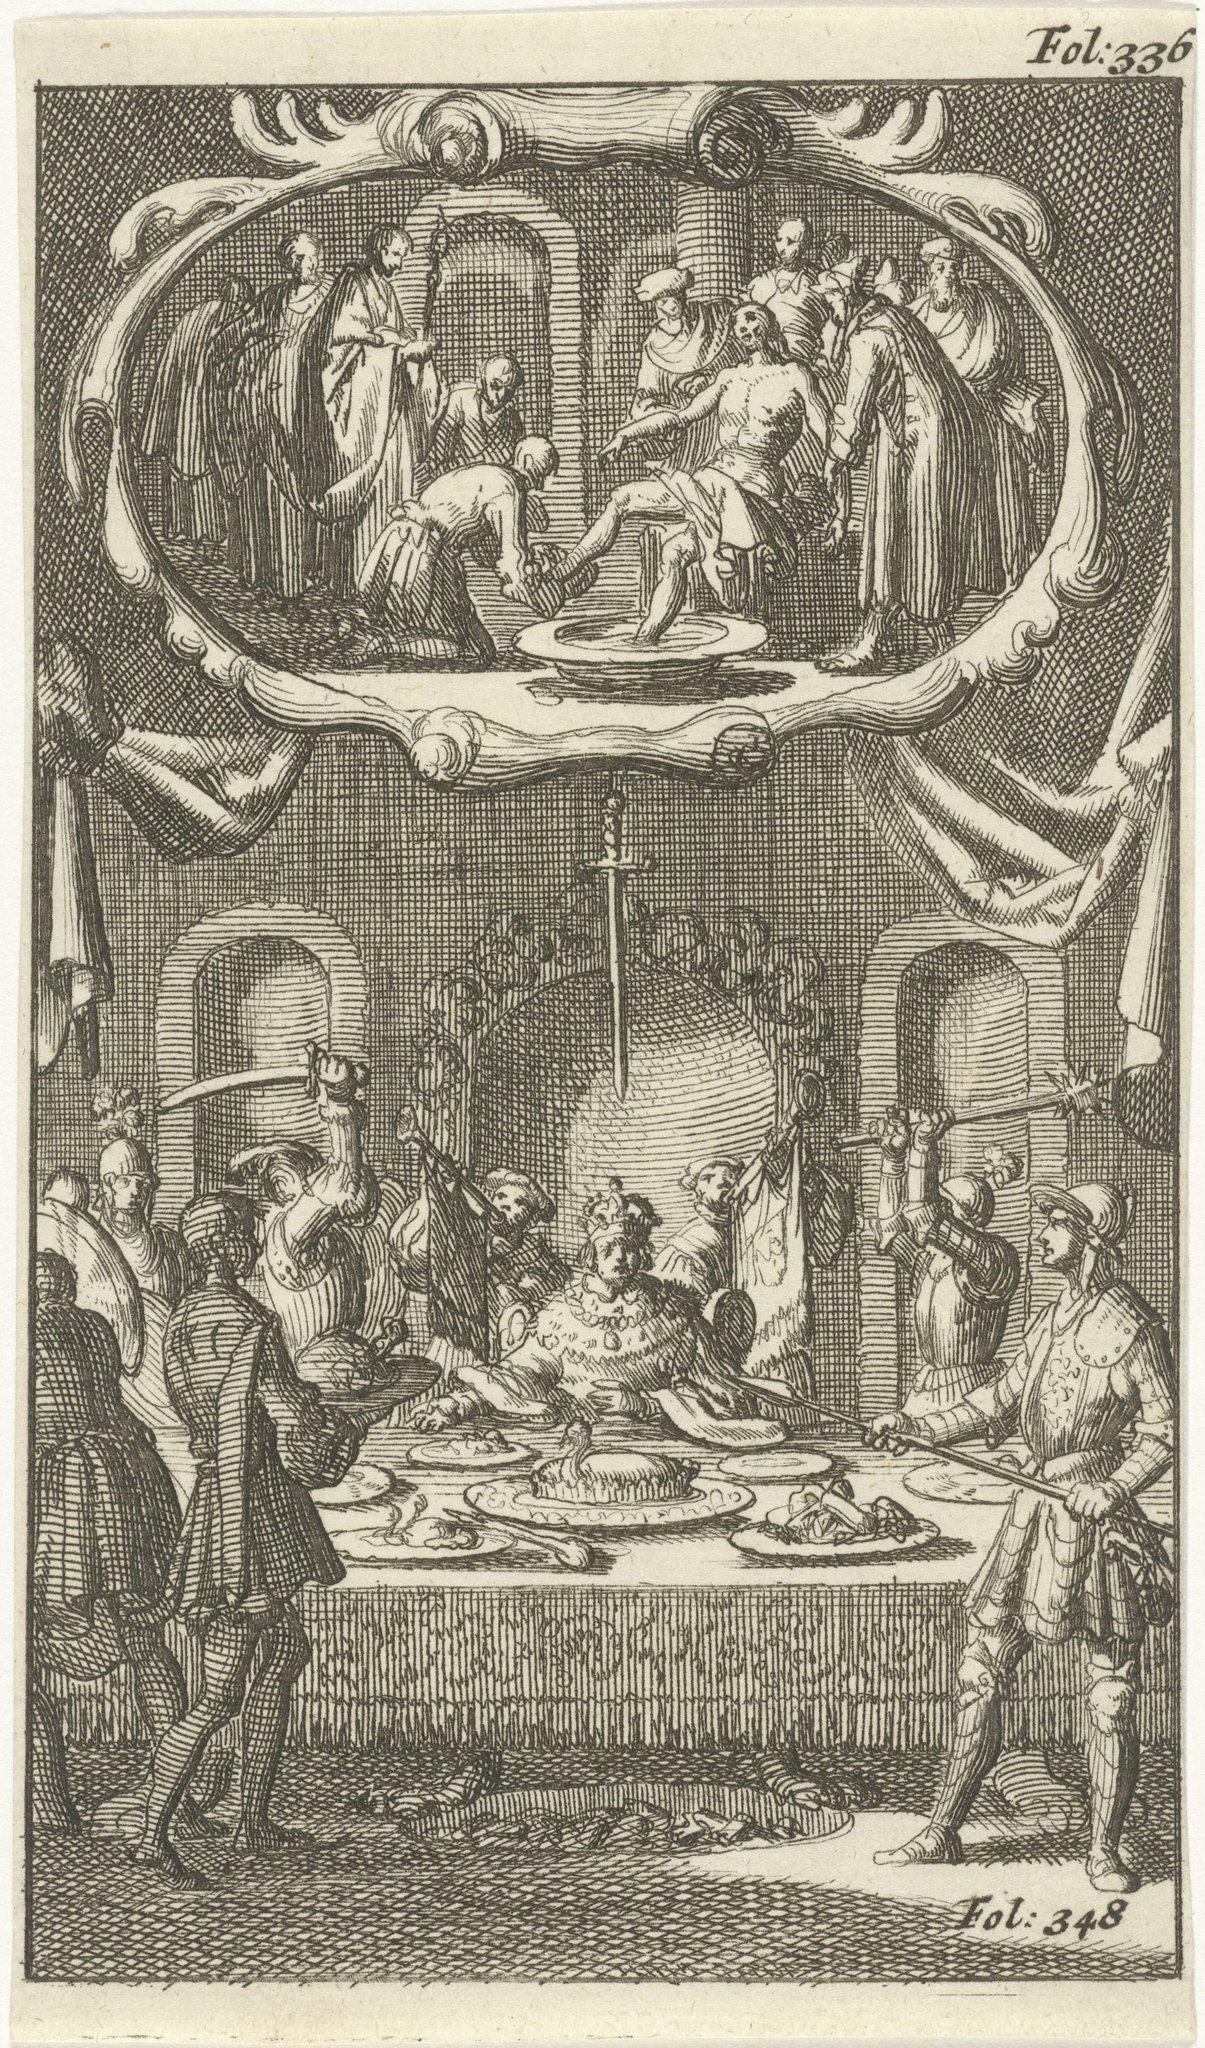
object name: print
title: Dood van Seneca / Jongeman wordt door gewapende figuren bedreigd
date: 1687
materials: paper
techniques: etching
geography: amsterdam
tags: threatening behaviour, challenging, death of seneca: at nero's order he cuts his veins, usually sitting in a basin or bath of water, and then takes a dose of poison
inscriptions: collector's mark: Lugt 2228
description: Illustratie uit: Ziegler, Georg. Konst-spiegel der weereltlikke vermaken. Amsterdam: Johannes Boekholt, 1687.